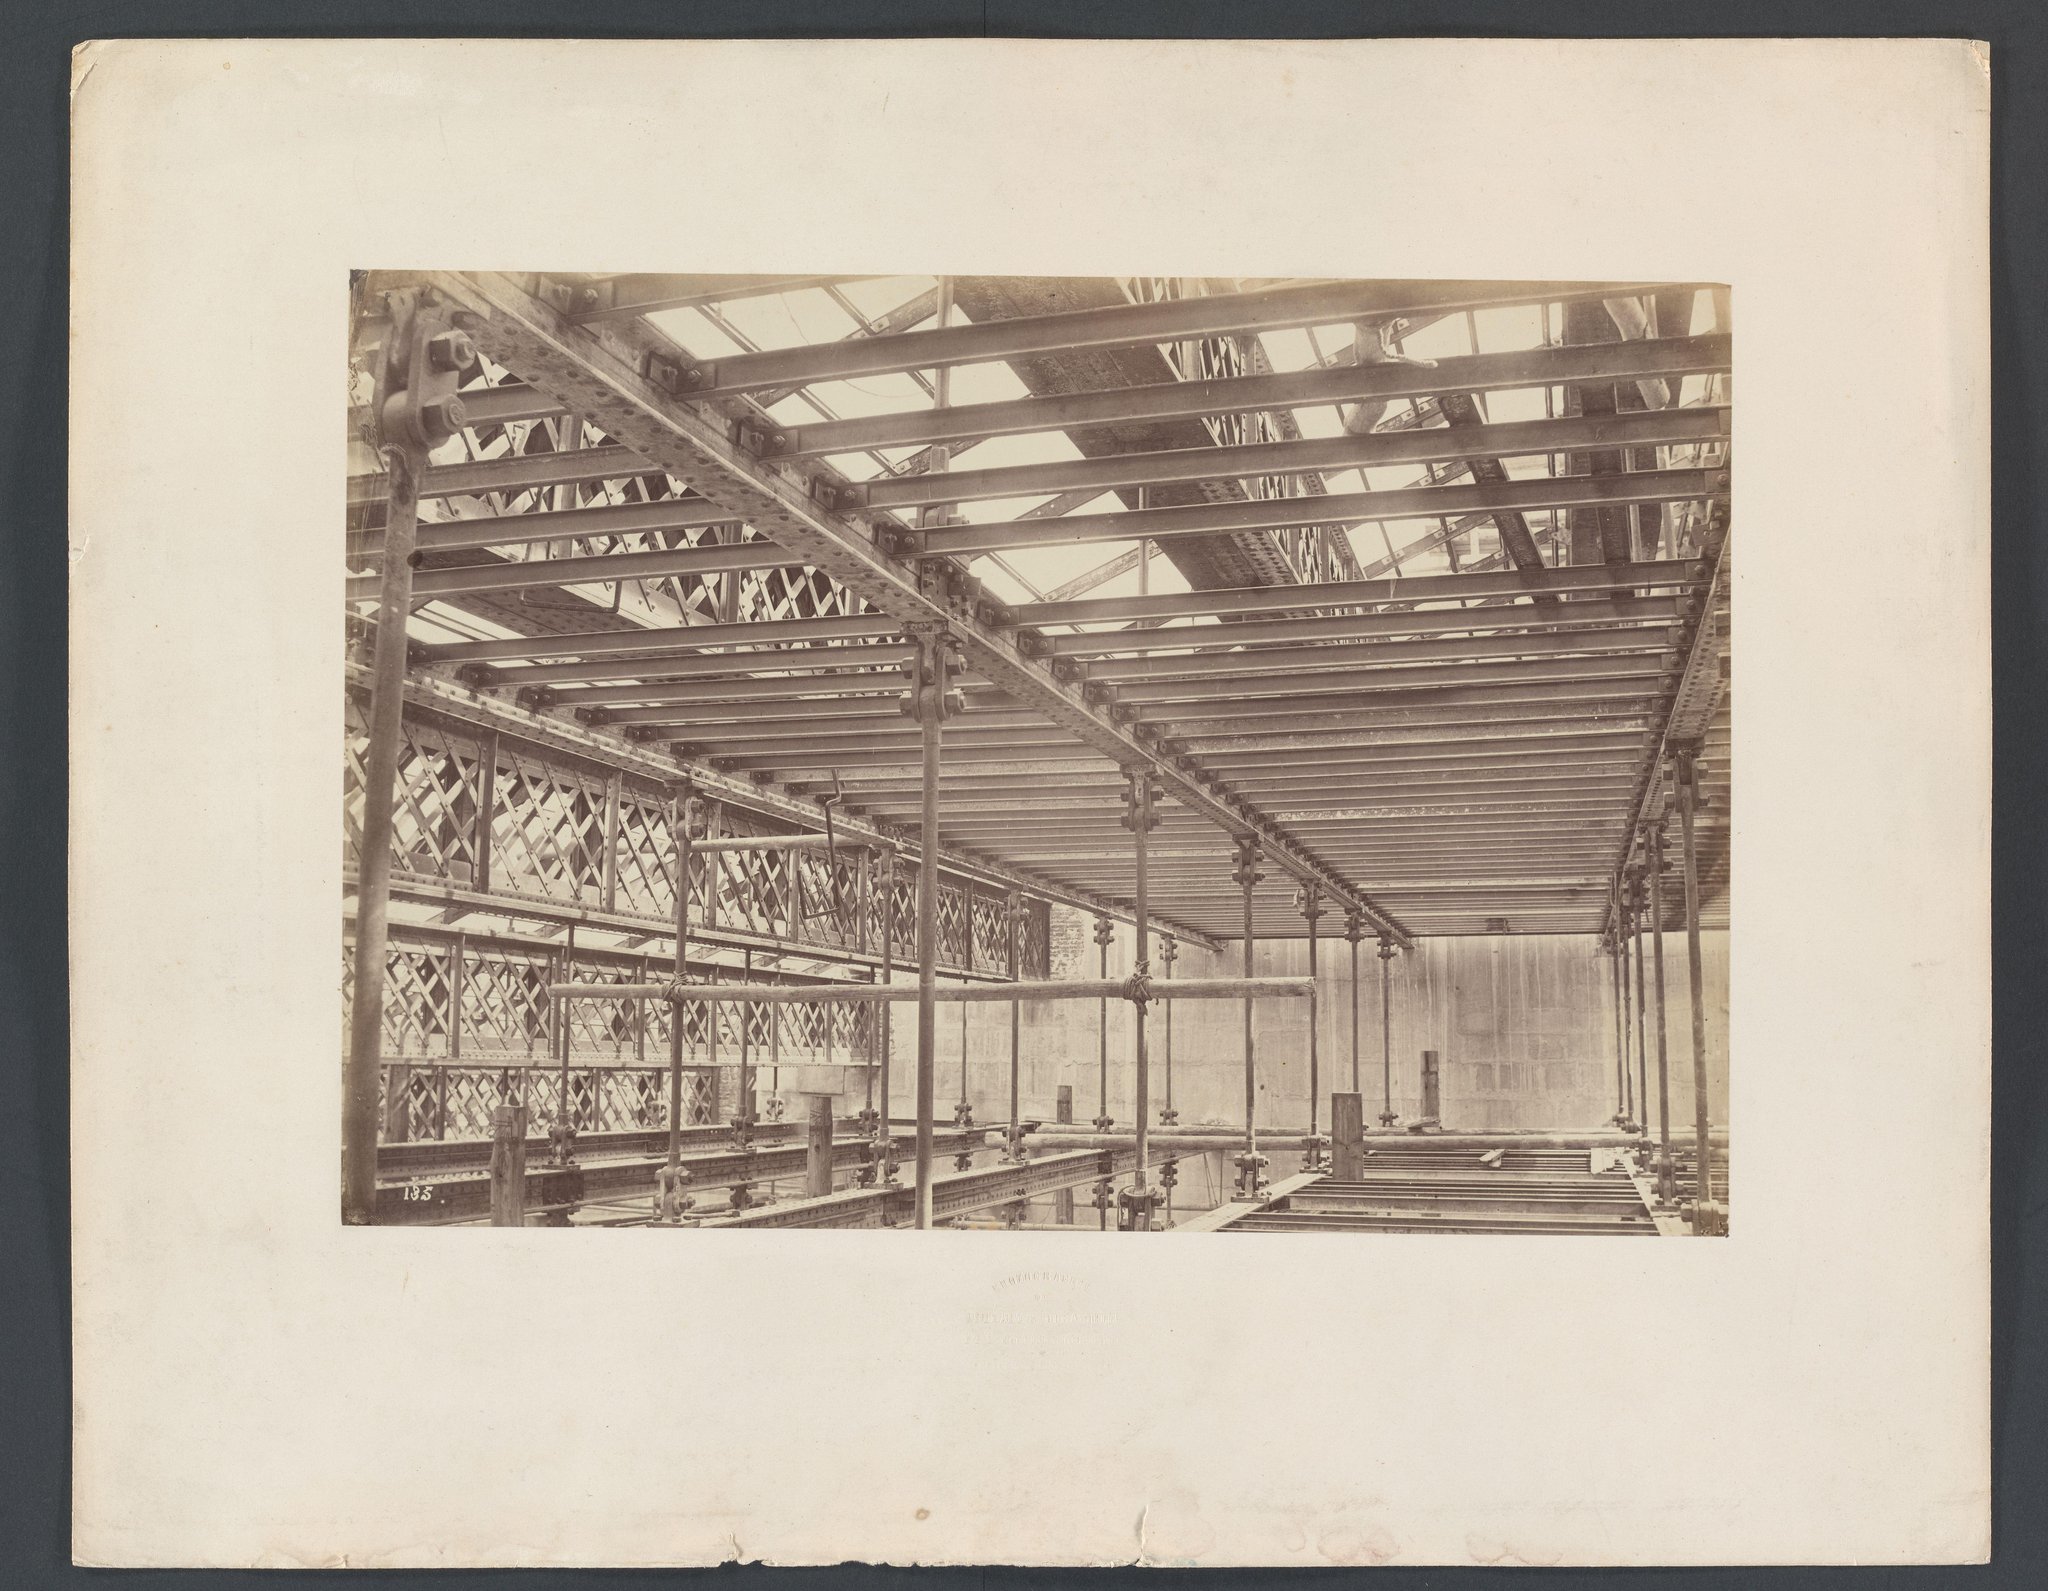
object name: photograph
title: IJzeren constructie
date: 1865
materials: cardboard, paper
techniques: albumen print